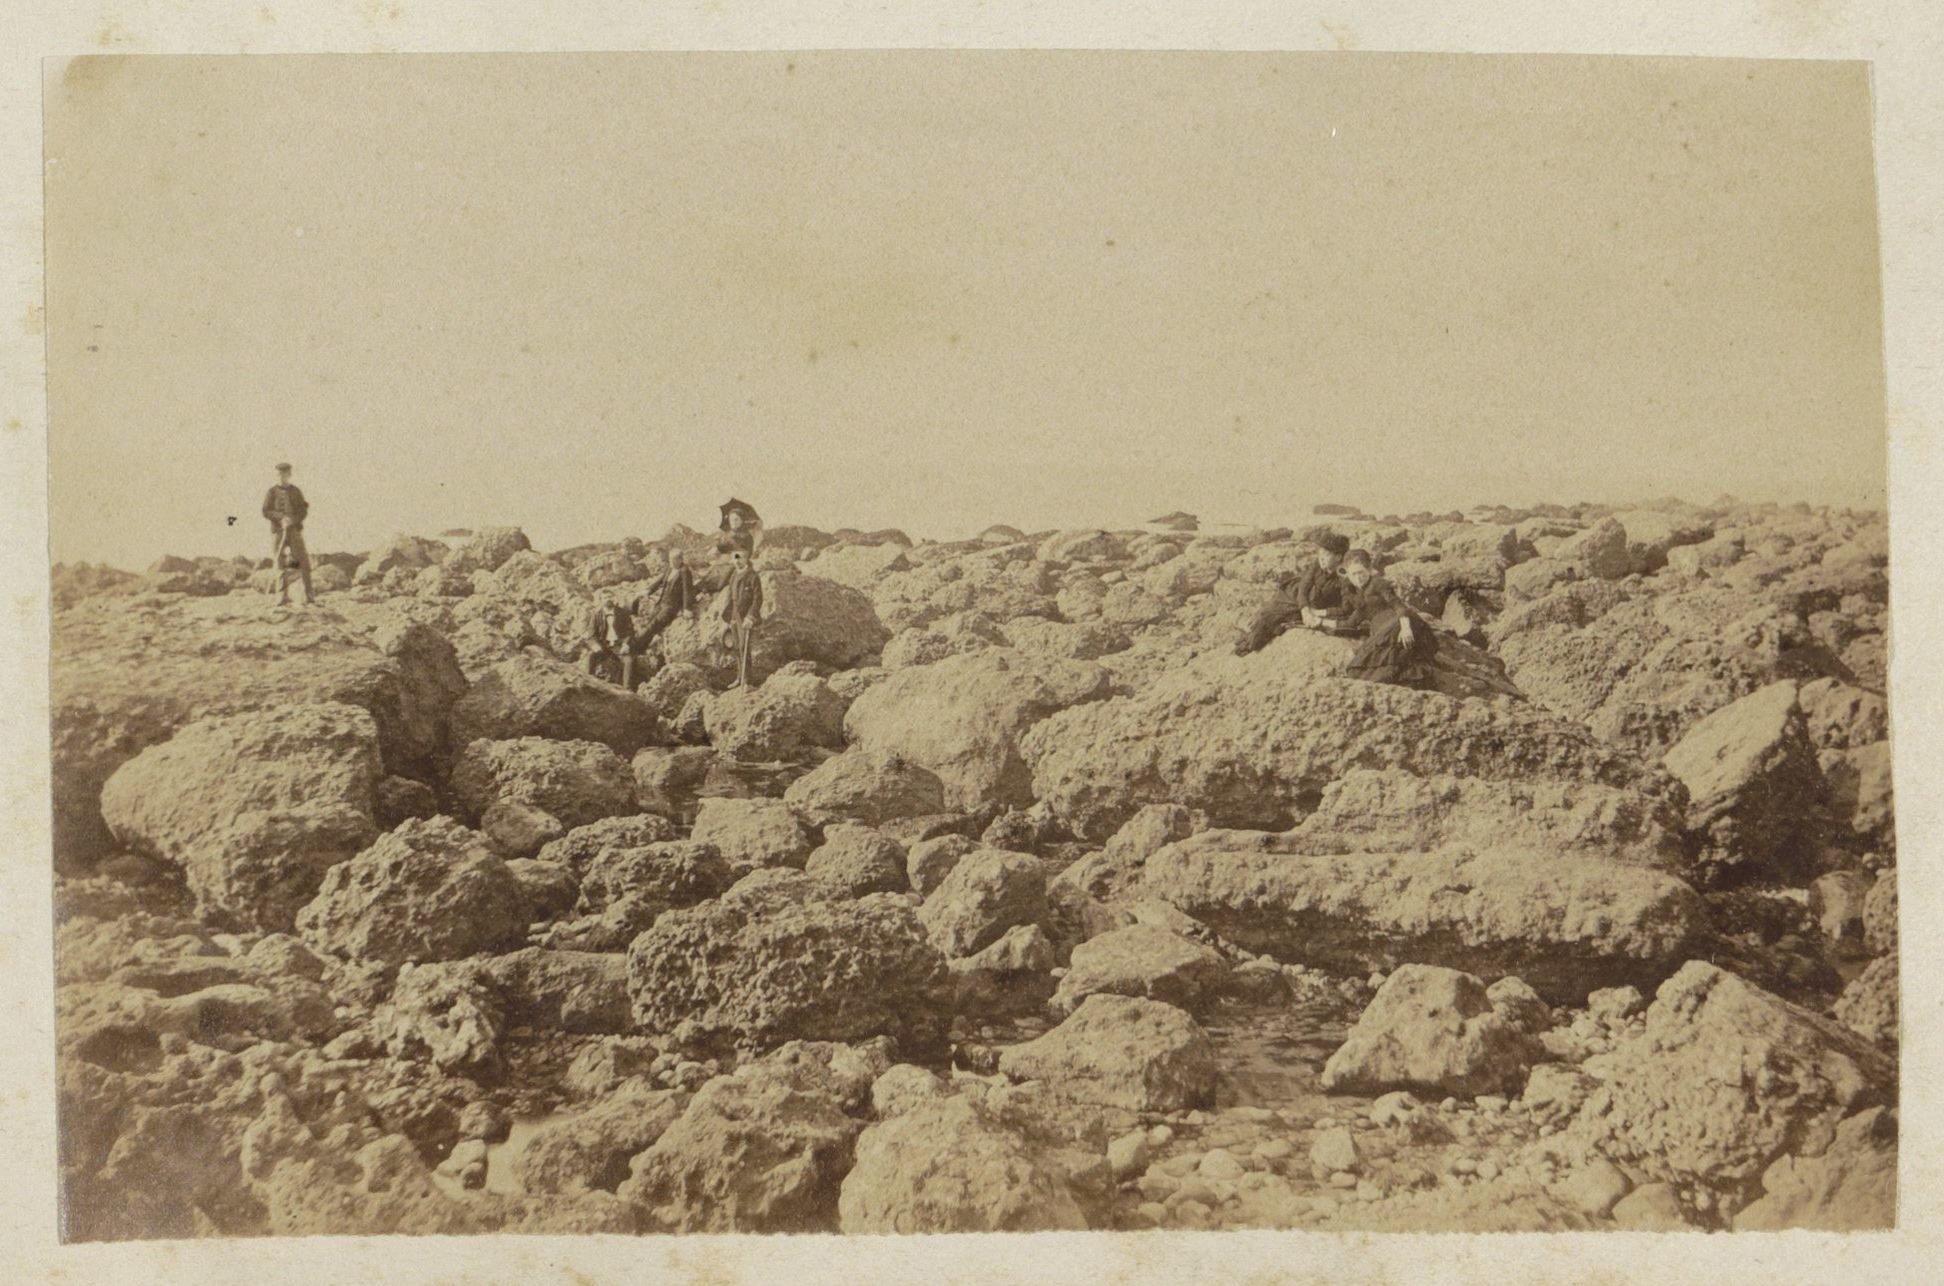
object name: photograph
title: Gezelschap staand op rotsen in Frankrijk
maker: Anonymous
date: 1809-1883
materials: photographic support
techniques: albumen print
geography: france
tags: the family travelling, on holiday, rock-formations, france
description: Onderdeel van Album van een Franse amateurfotograaf met opnames van familie, militairen, industrie, landschappen en bezienswaardigheden in Frankrijk.